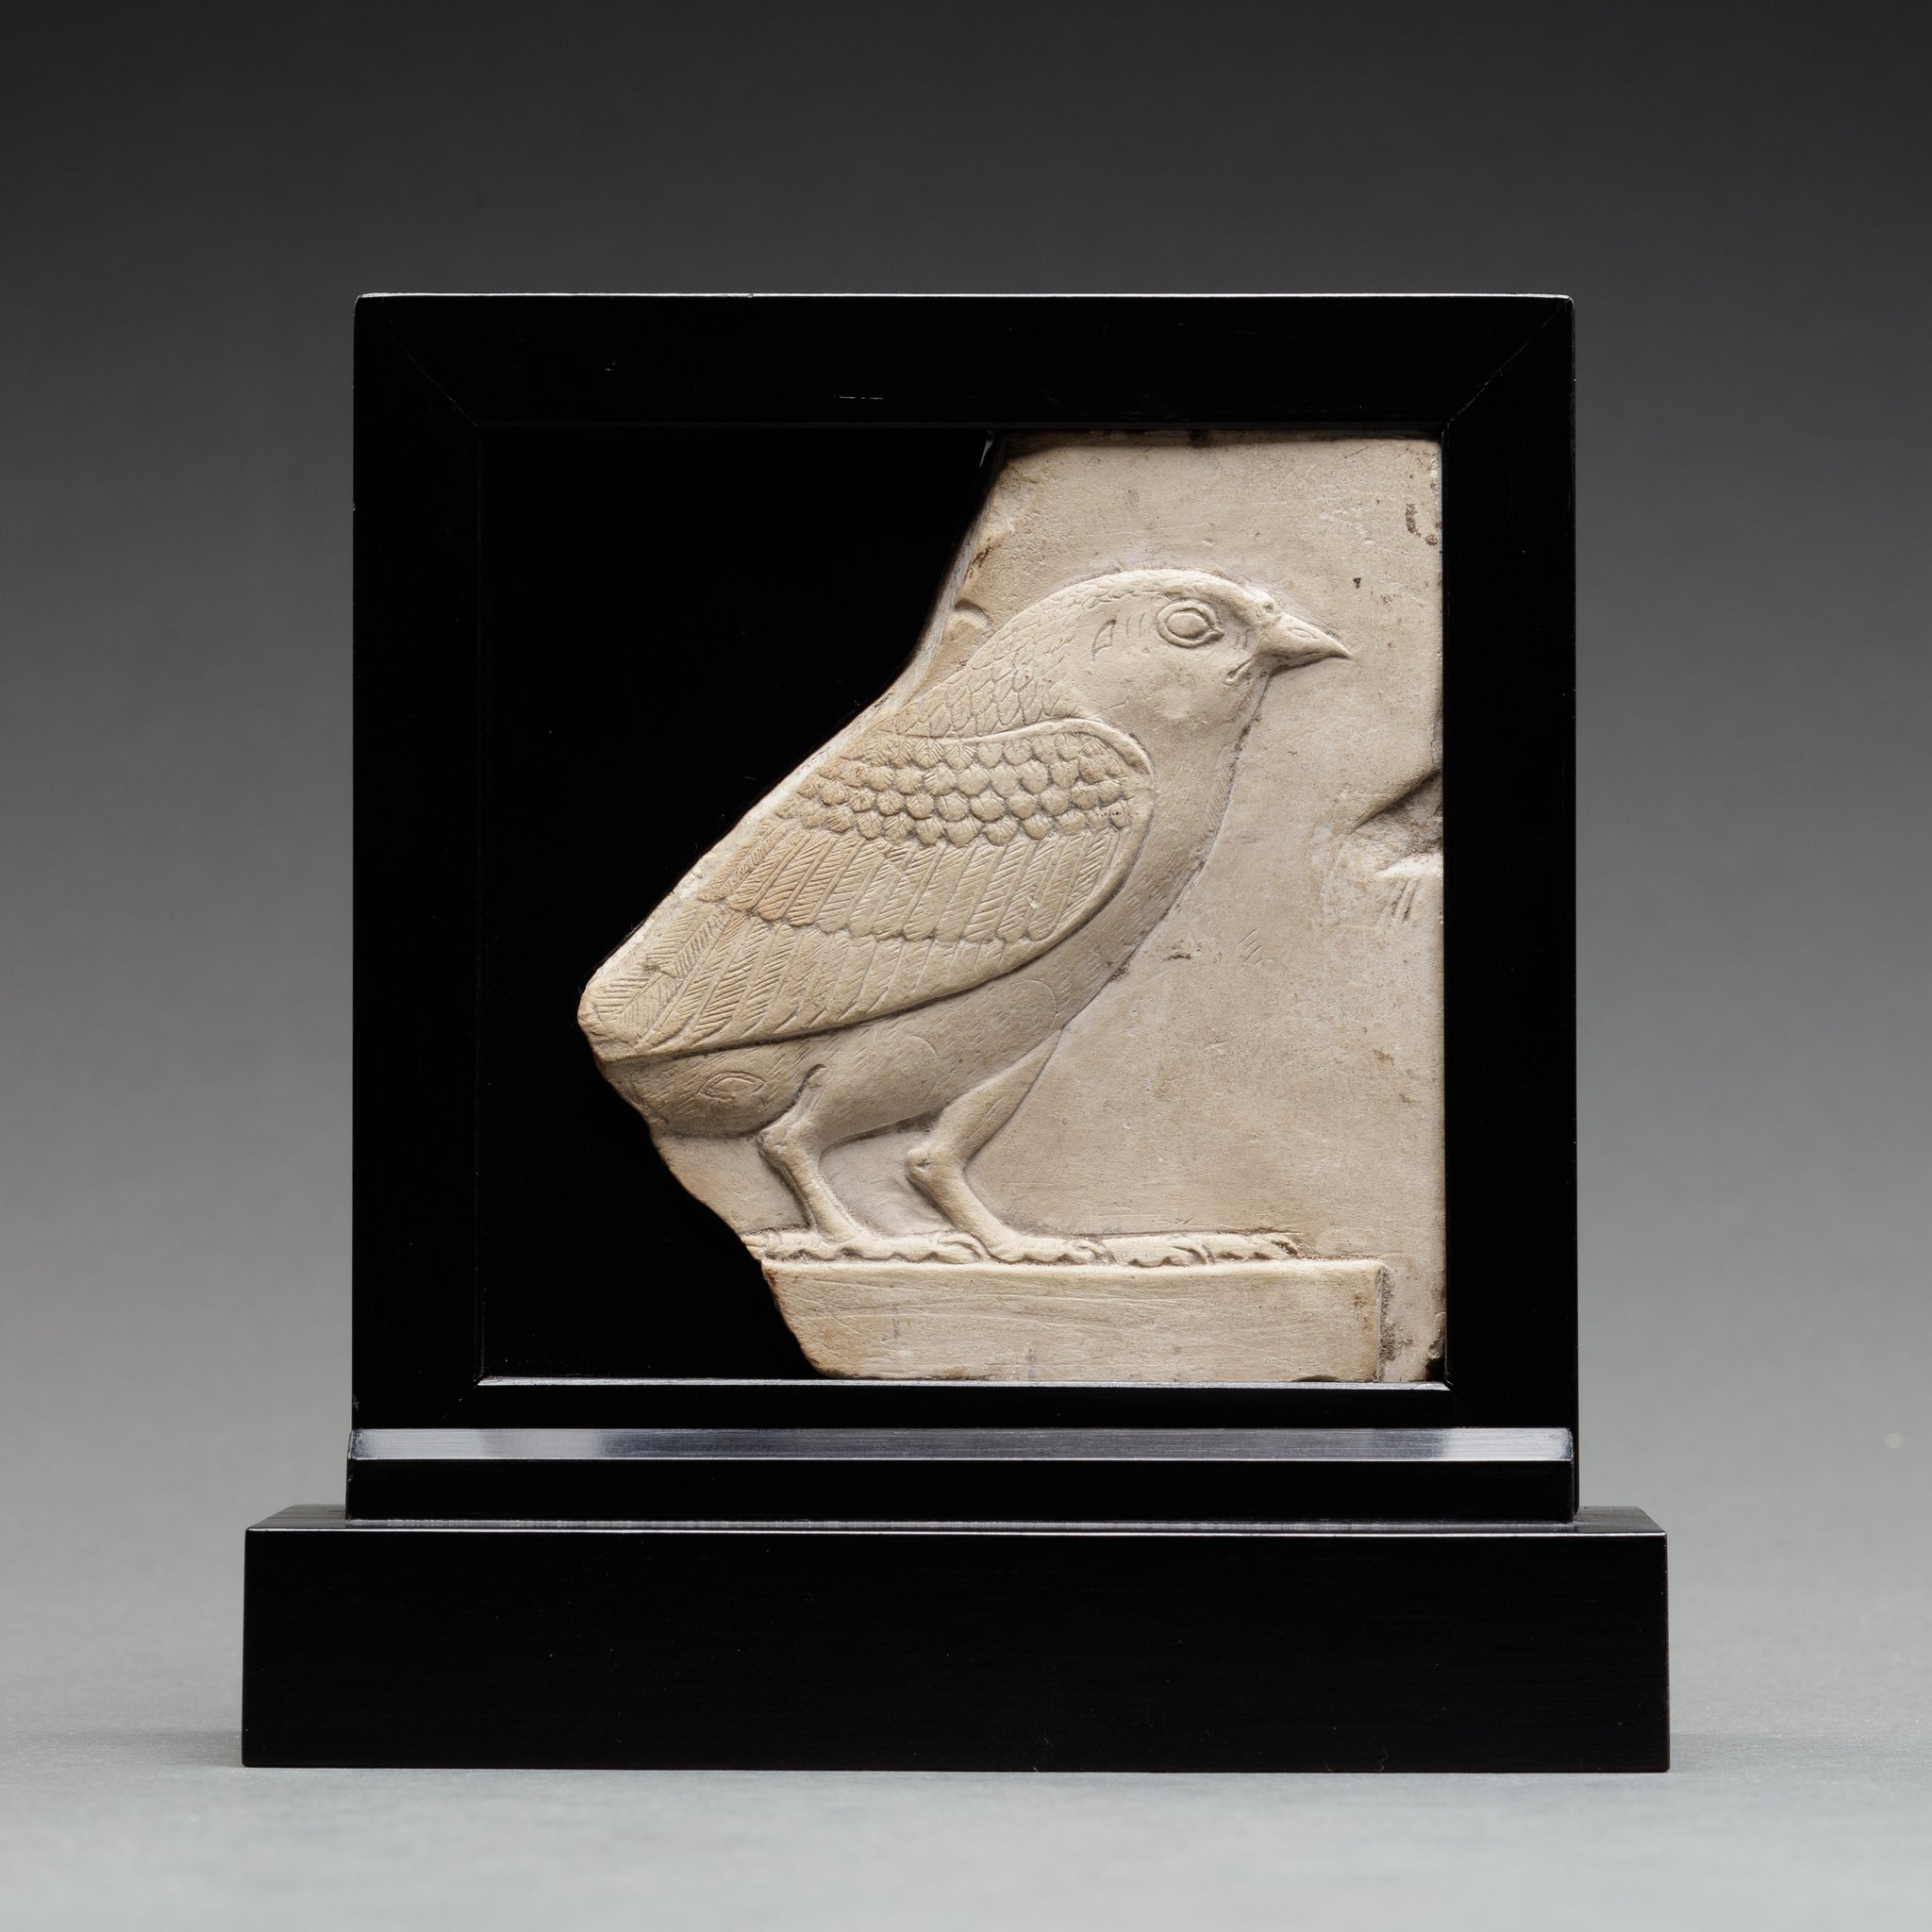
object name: relief, plaque, sculptor's model, donation, bird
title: Relief plaque with birds on both sides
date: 400-30 BCE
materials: limestone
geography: egypt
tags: birds